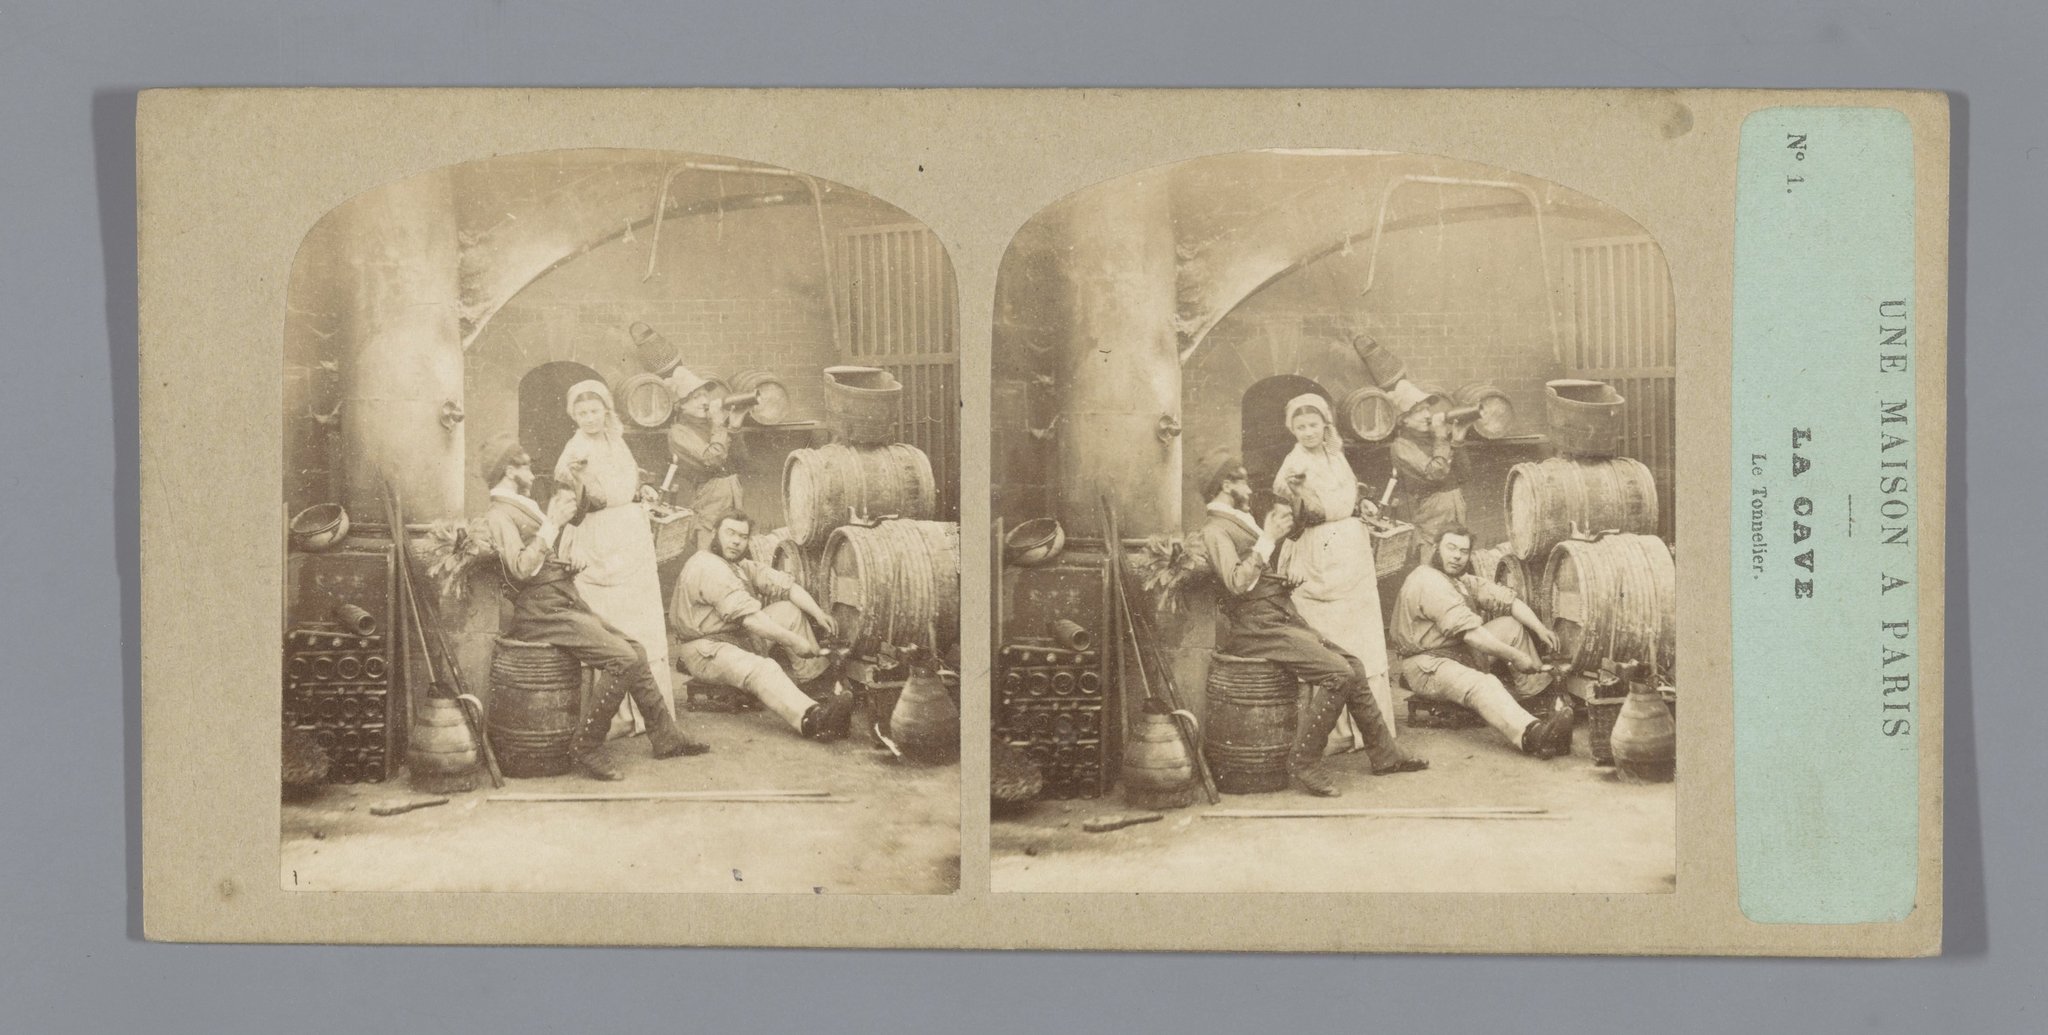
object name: stereograph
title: Theatrale voorstelling van drie mannen en een vrouw in een wijnkelder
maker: Anonymous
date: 1850-1880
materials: cardboard, photographic support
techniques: albumen print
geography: france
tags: wine-cellar, wine ~ alcoholic drinks, paris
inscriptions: number: ‘No 1.’, name: ‘Feldbrugge & Co Groningen’, inscription: ‘do-70’